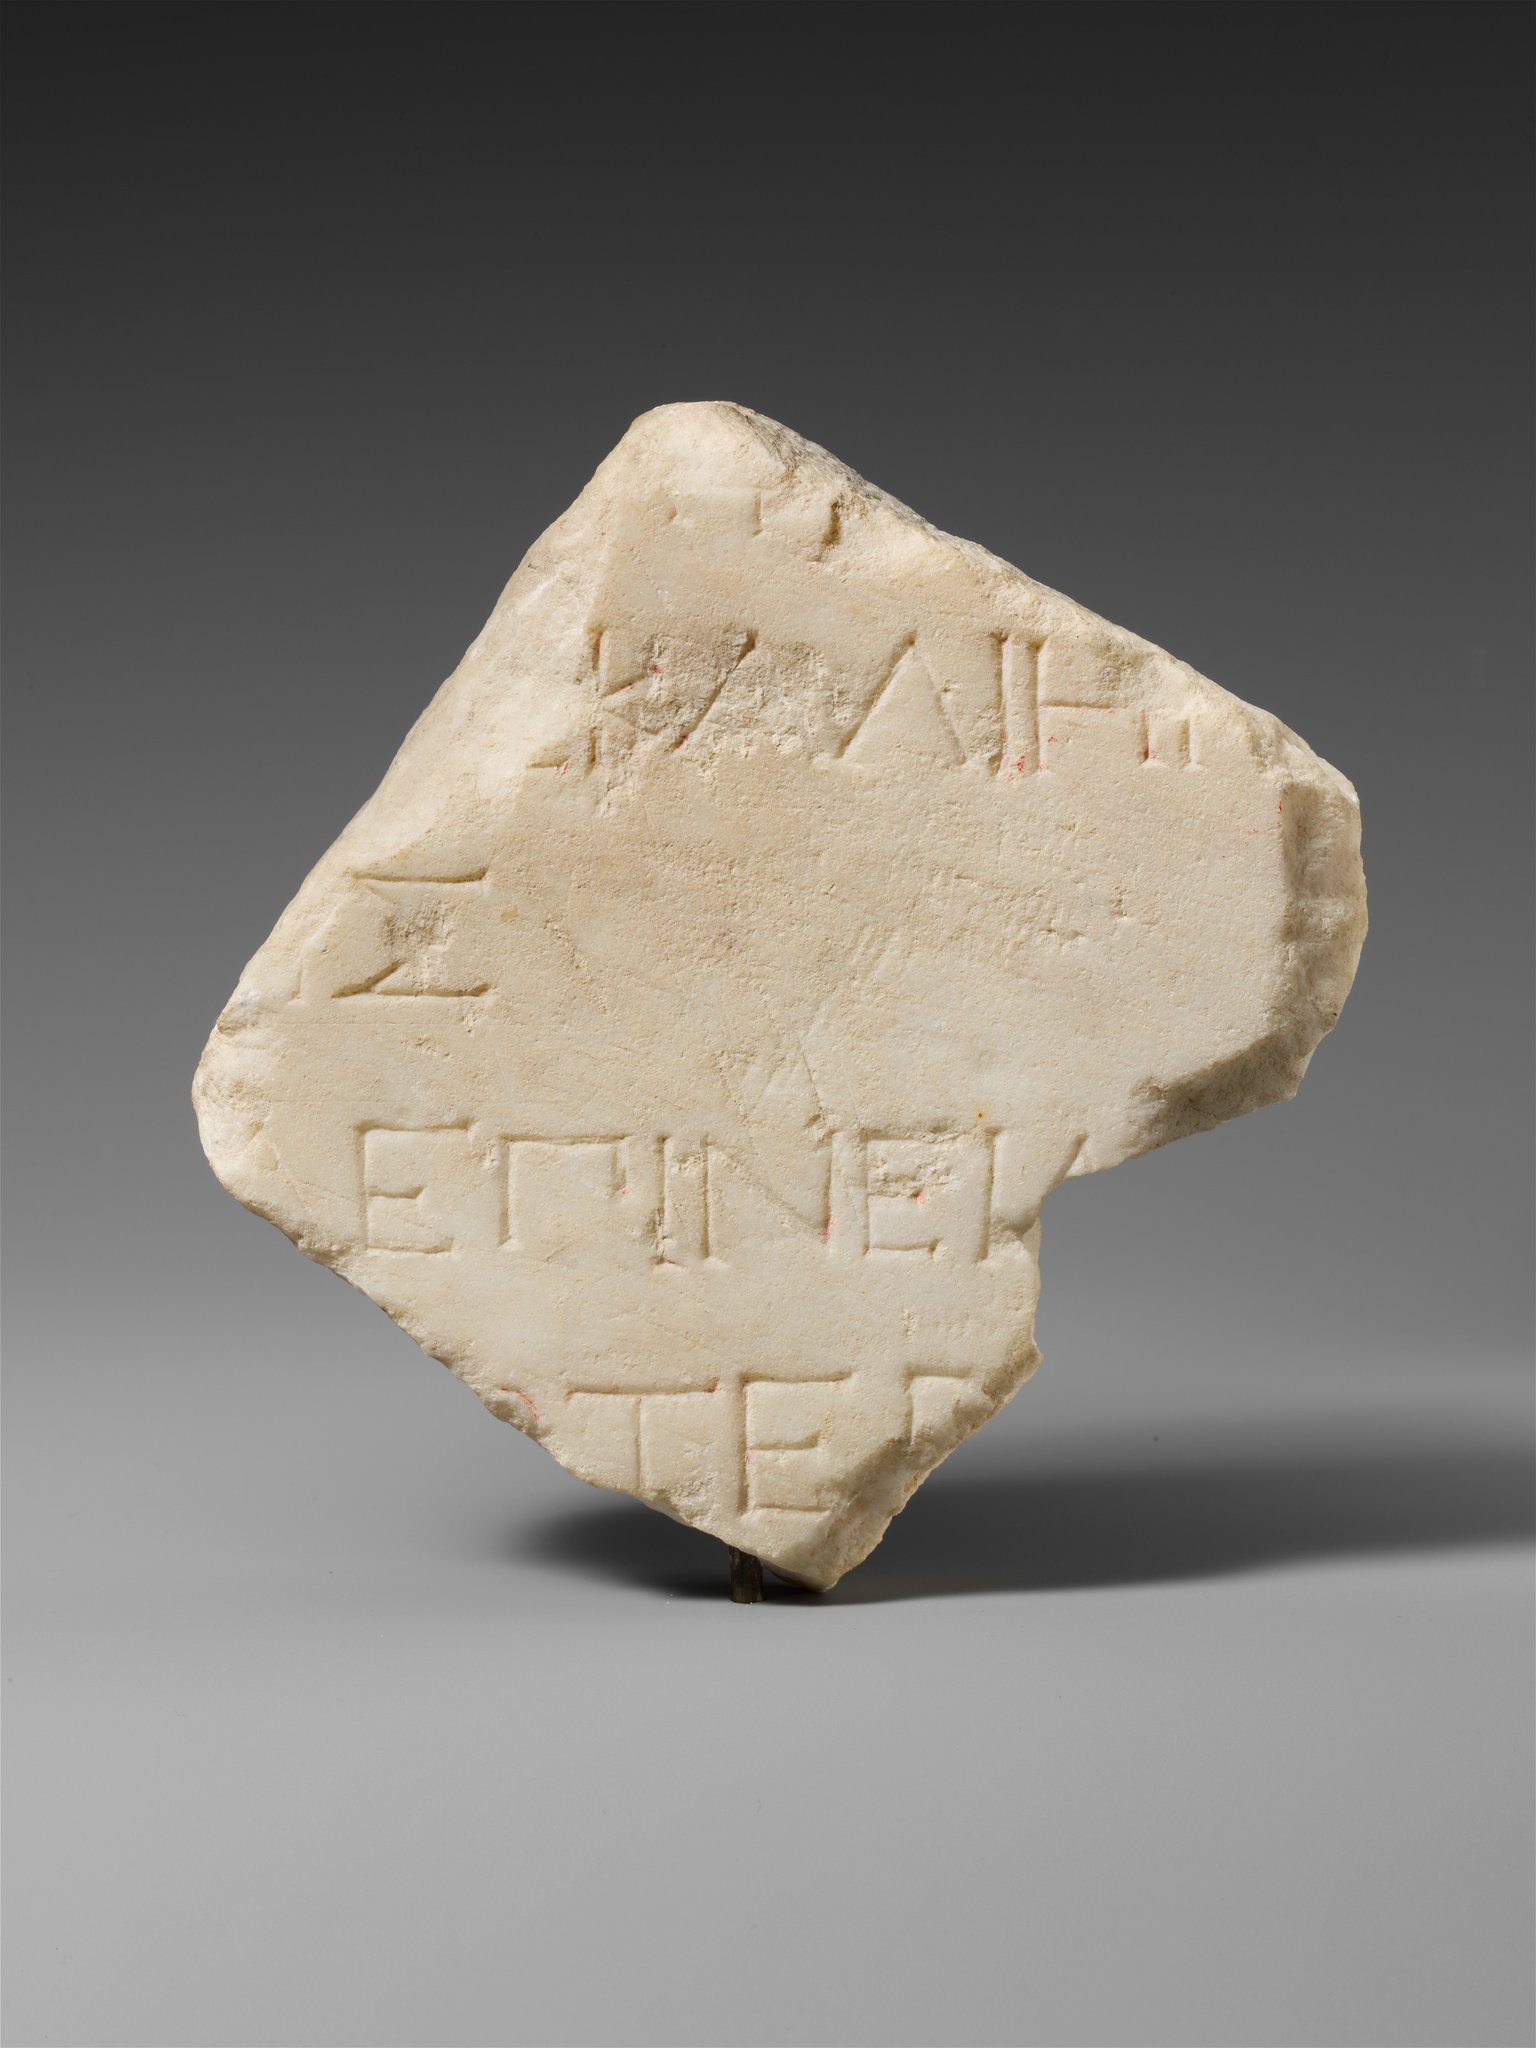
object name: inscription, fragment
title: Marble fragmentary inscribed block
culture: cypriot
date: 400-301 BCE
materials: marble